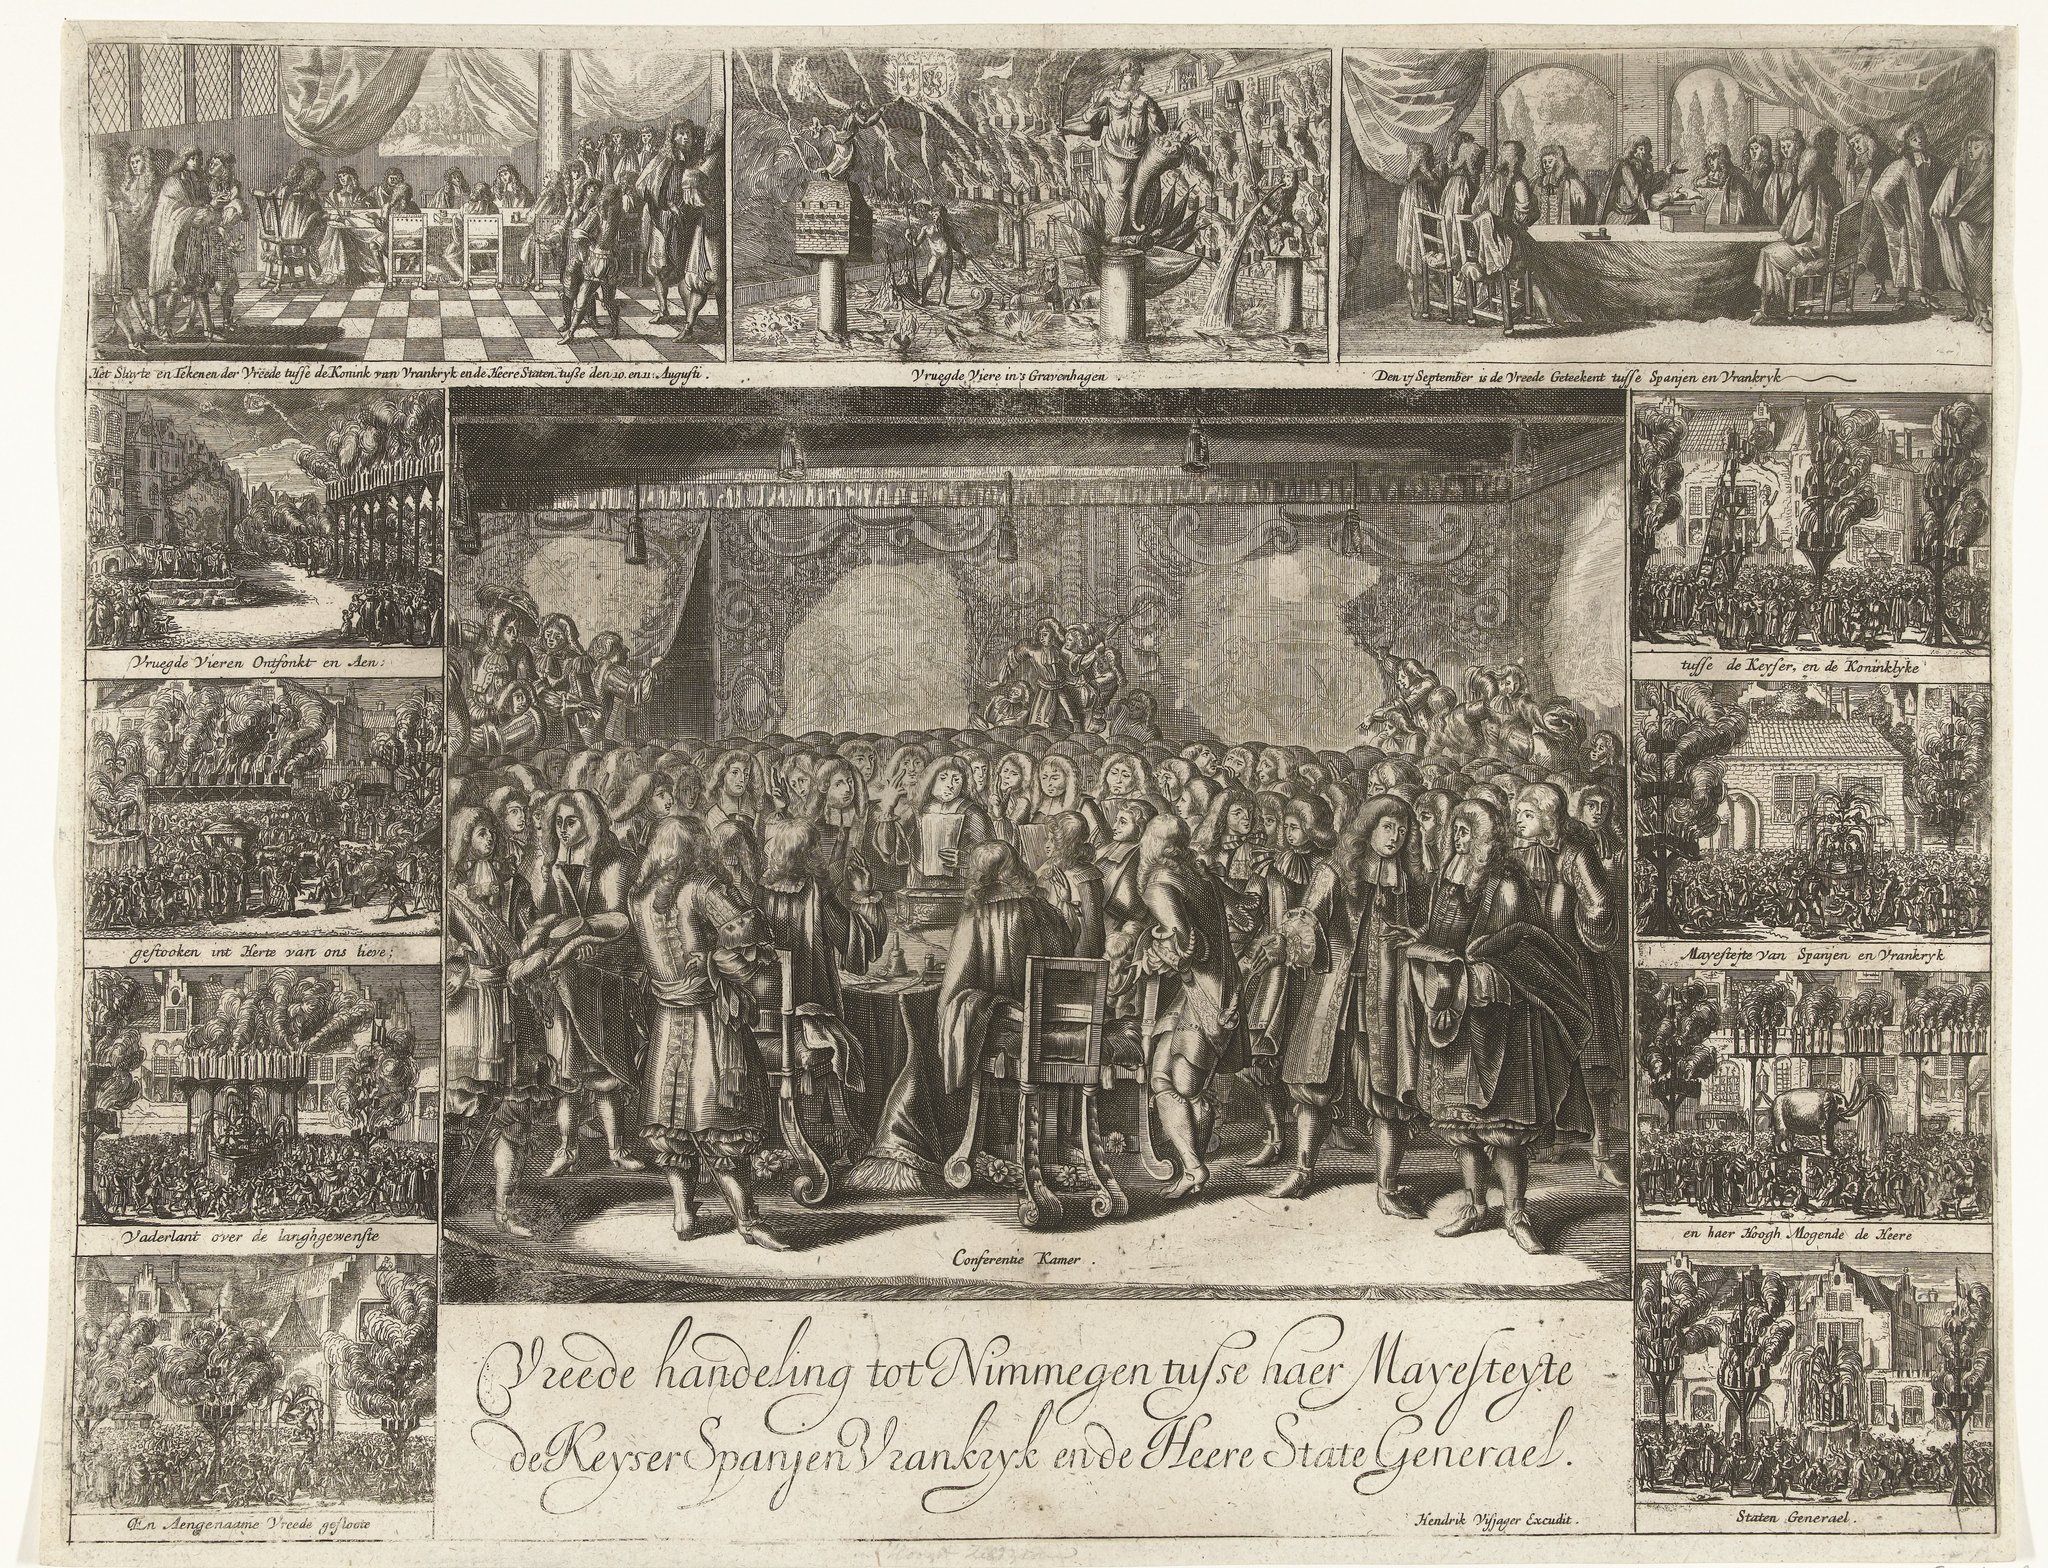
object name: print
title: De vrede van Nijmegen, 1678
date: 1678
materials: paper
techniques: engraving, etching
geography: northern netherlands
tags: bonfire, fire-works, signing of peace treaty, concluding the peace, swearing an oath (with two fingers raised)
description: De vrede van Nijmegen. Centraal het afleggen van de eed op het vredesverdrag tussen de Republiek en Frankrijk op 10 augustus 1678. Centrale voorstelling van de afgevaardigden verzameld rond een tafel in een zaal. Hieromheen kleinere voorstellingen van het vieren van de vrede in verschillende steden en (rechtsboven) het sluiten van de vrede tussen Spanje en Frankrijk op 17 september.